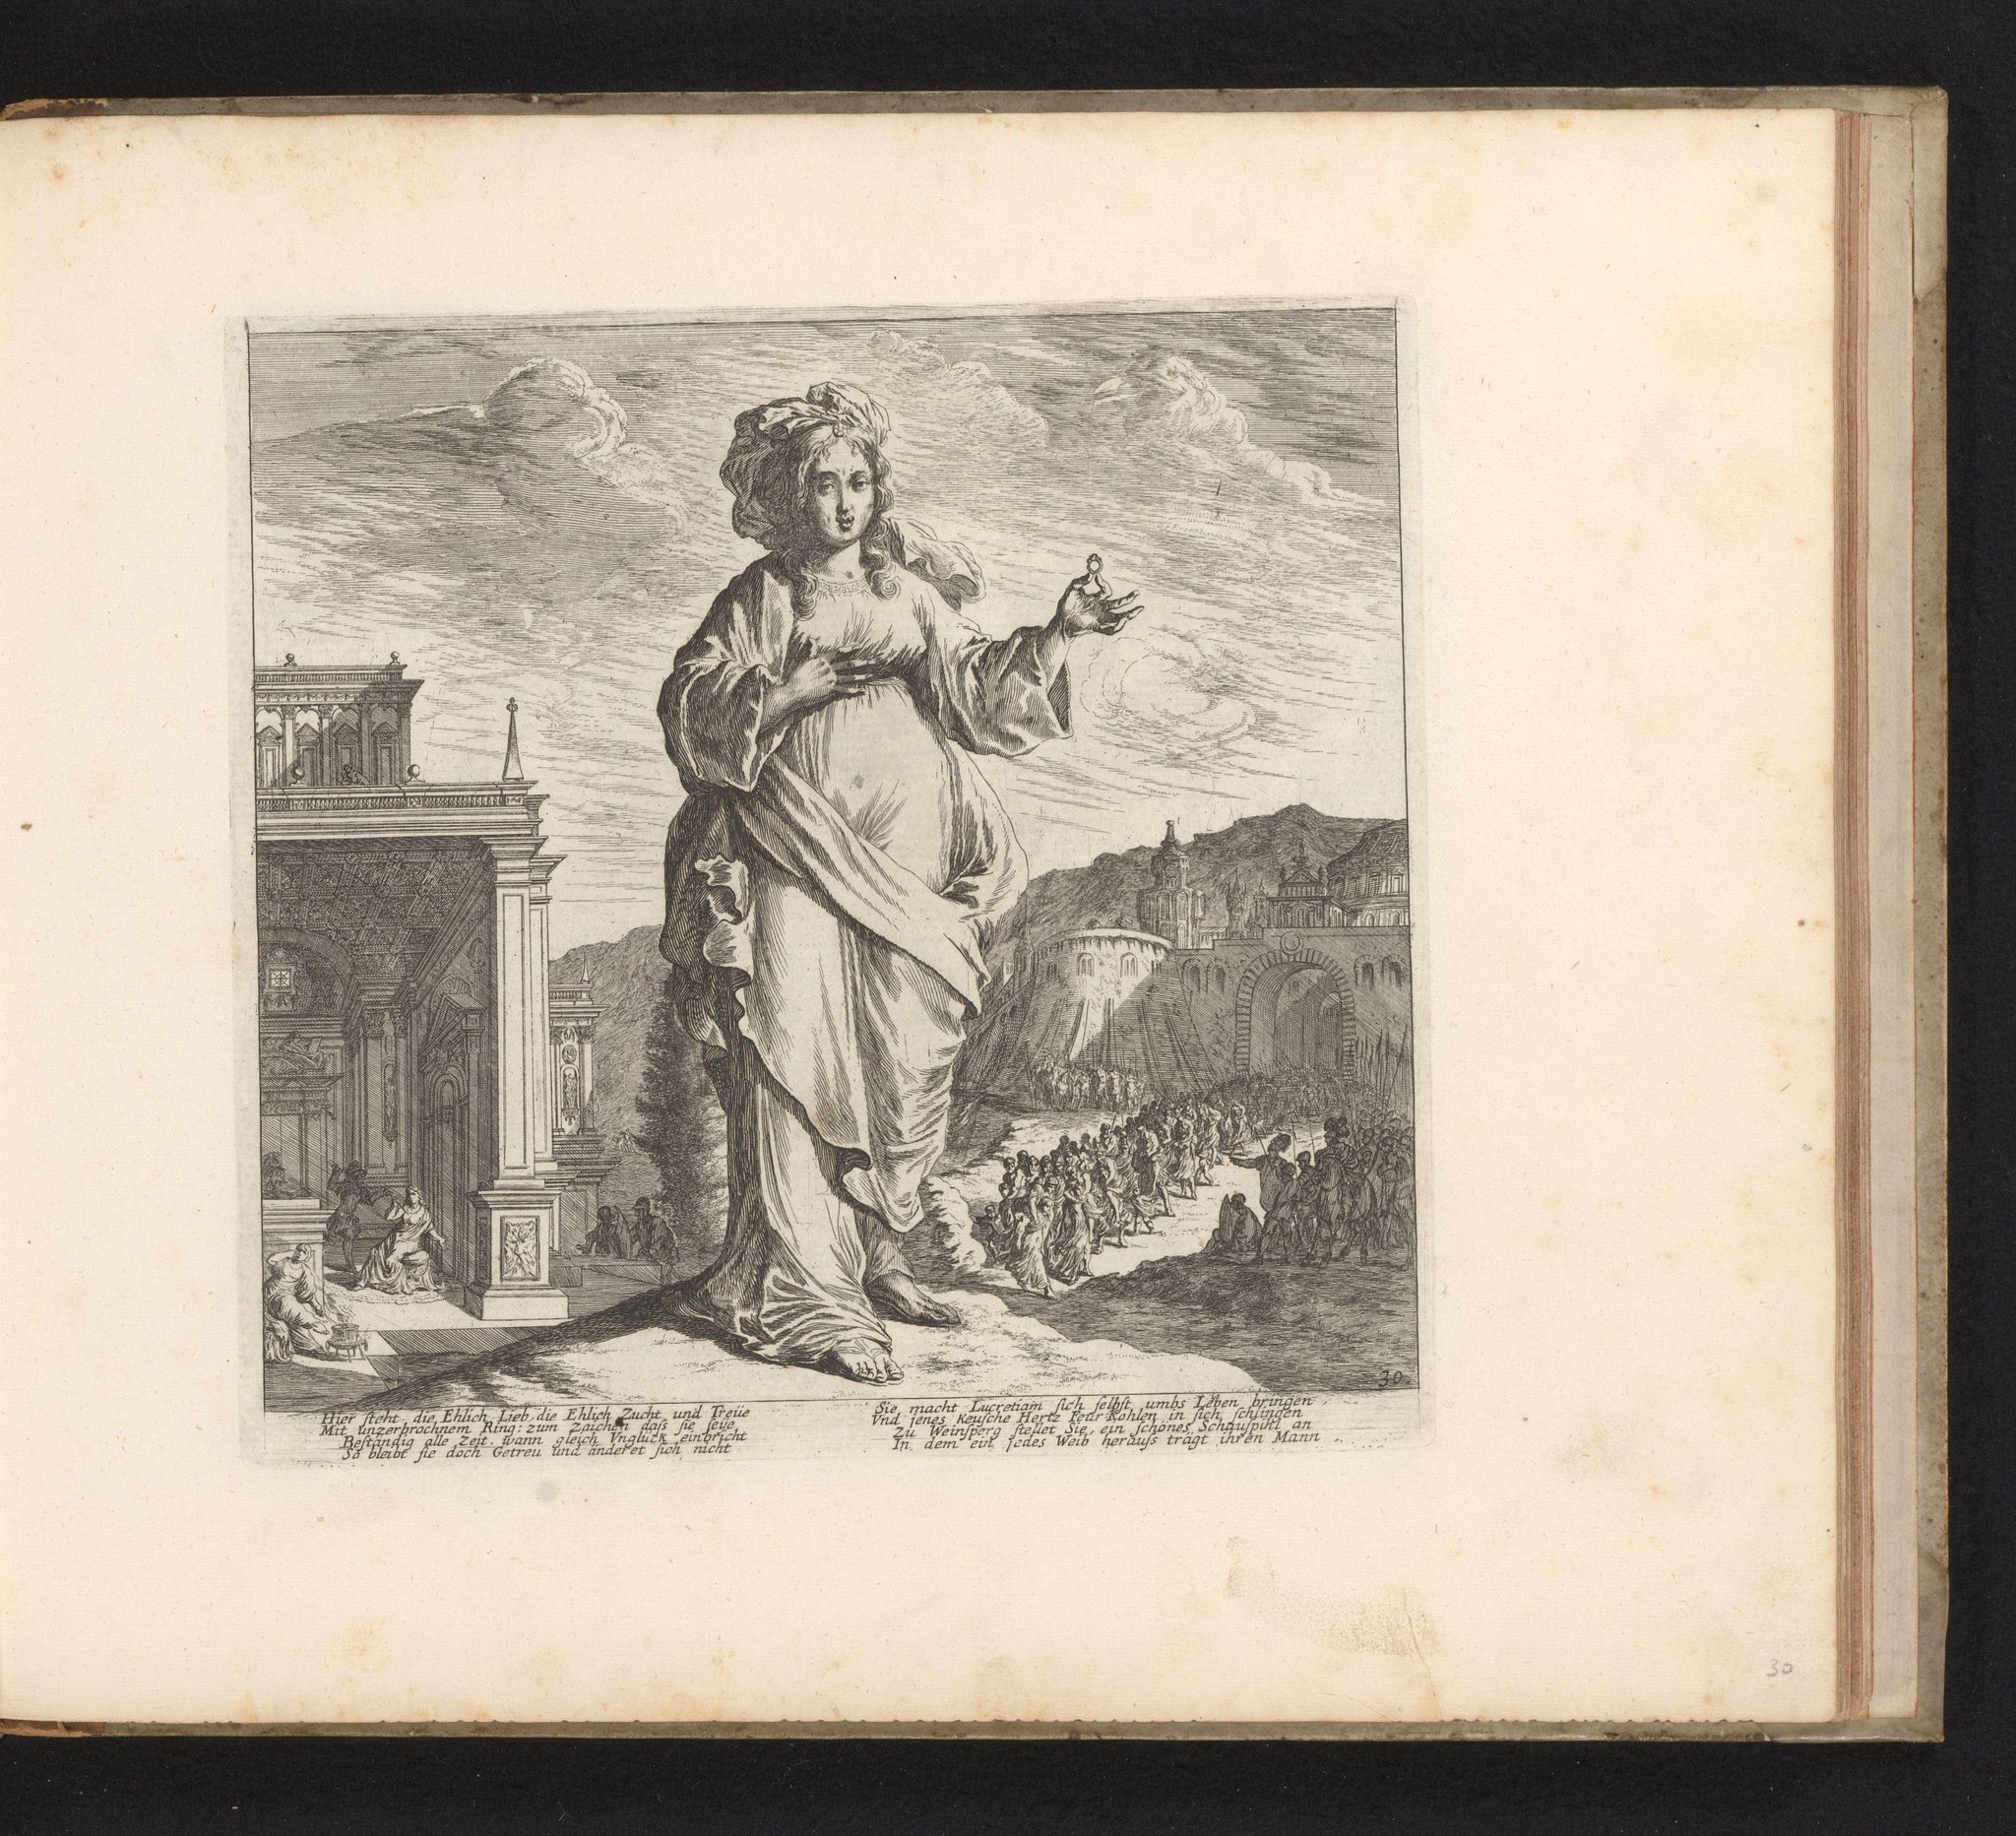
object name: album leaf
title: Personificatie van Trouw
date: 1670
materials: paper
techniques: etching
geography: augsburg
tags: fidelity; 'fedeltà' (ripa) (+ allegorical scene, i.e. two or more personifications involved in an action)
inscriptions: collector's mark: Lugt 2228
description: Centraal een personificatie van (huwelijkse) trouw. Rechtsonder tillen de vrouwen uit Weinsberg hun man op de schouder de stad uit ('Weibertreu'). Tekst in het Duits in de ondermarge. Rechtsonder genummerd: 30. Prent maakt deel uit van een album.